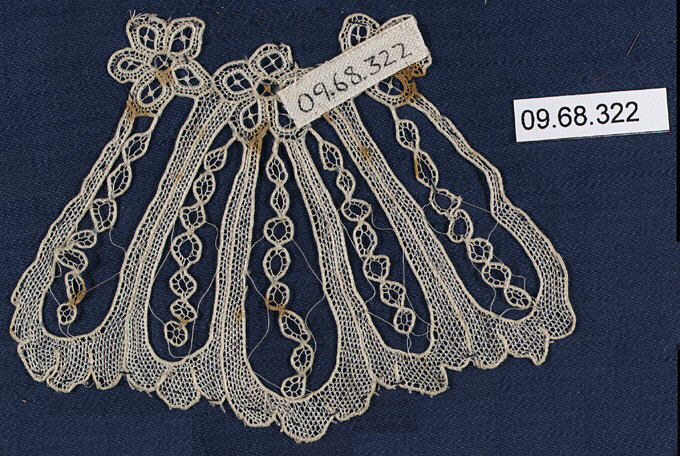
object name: fragment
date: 1801-1900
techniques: lace